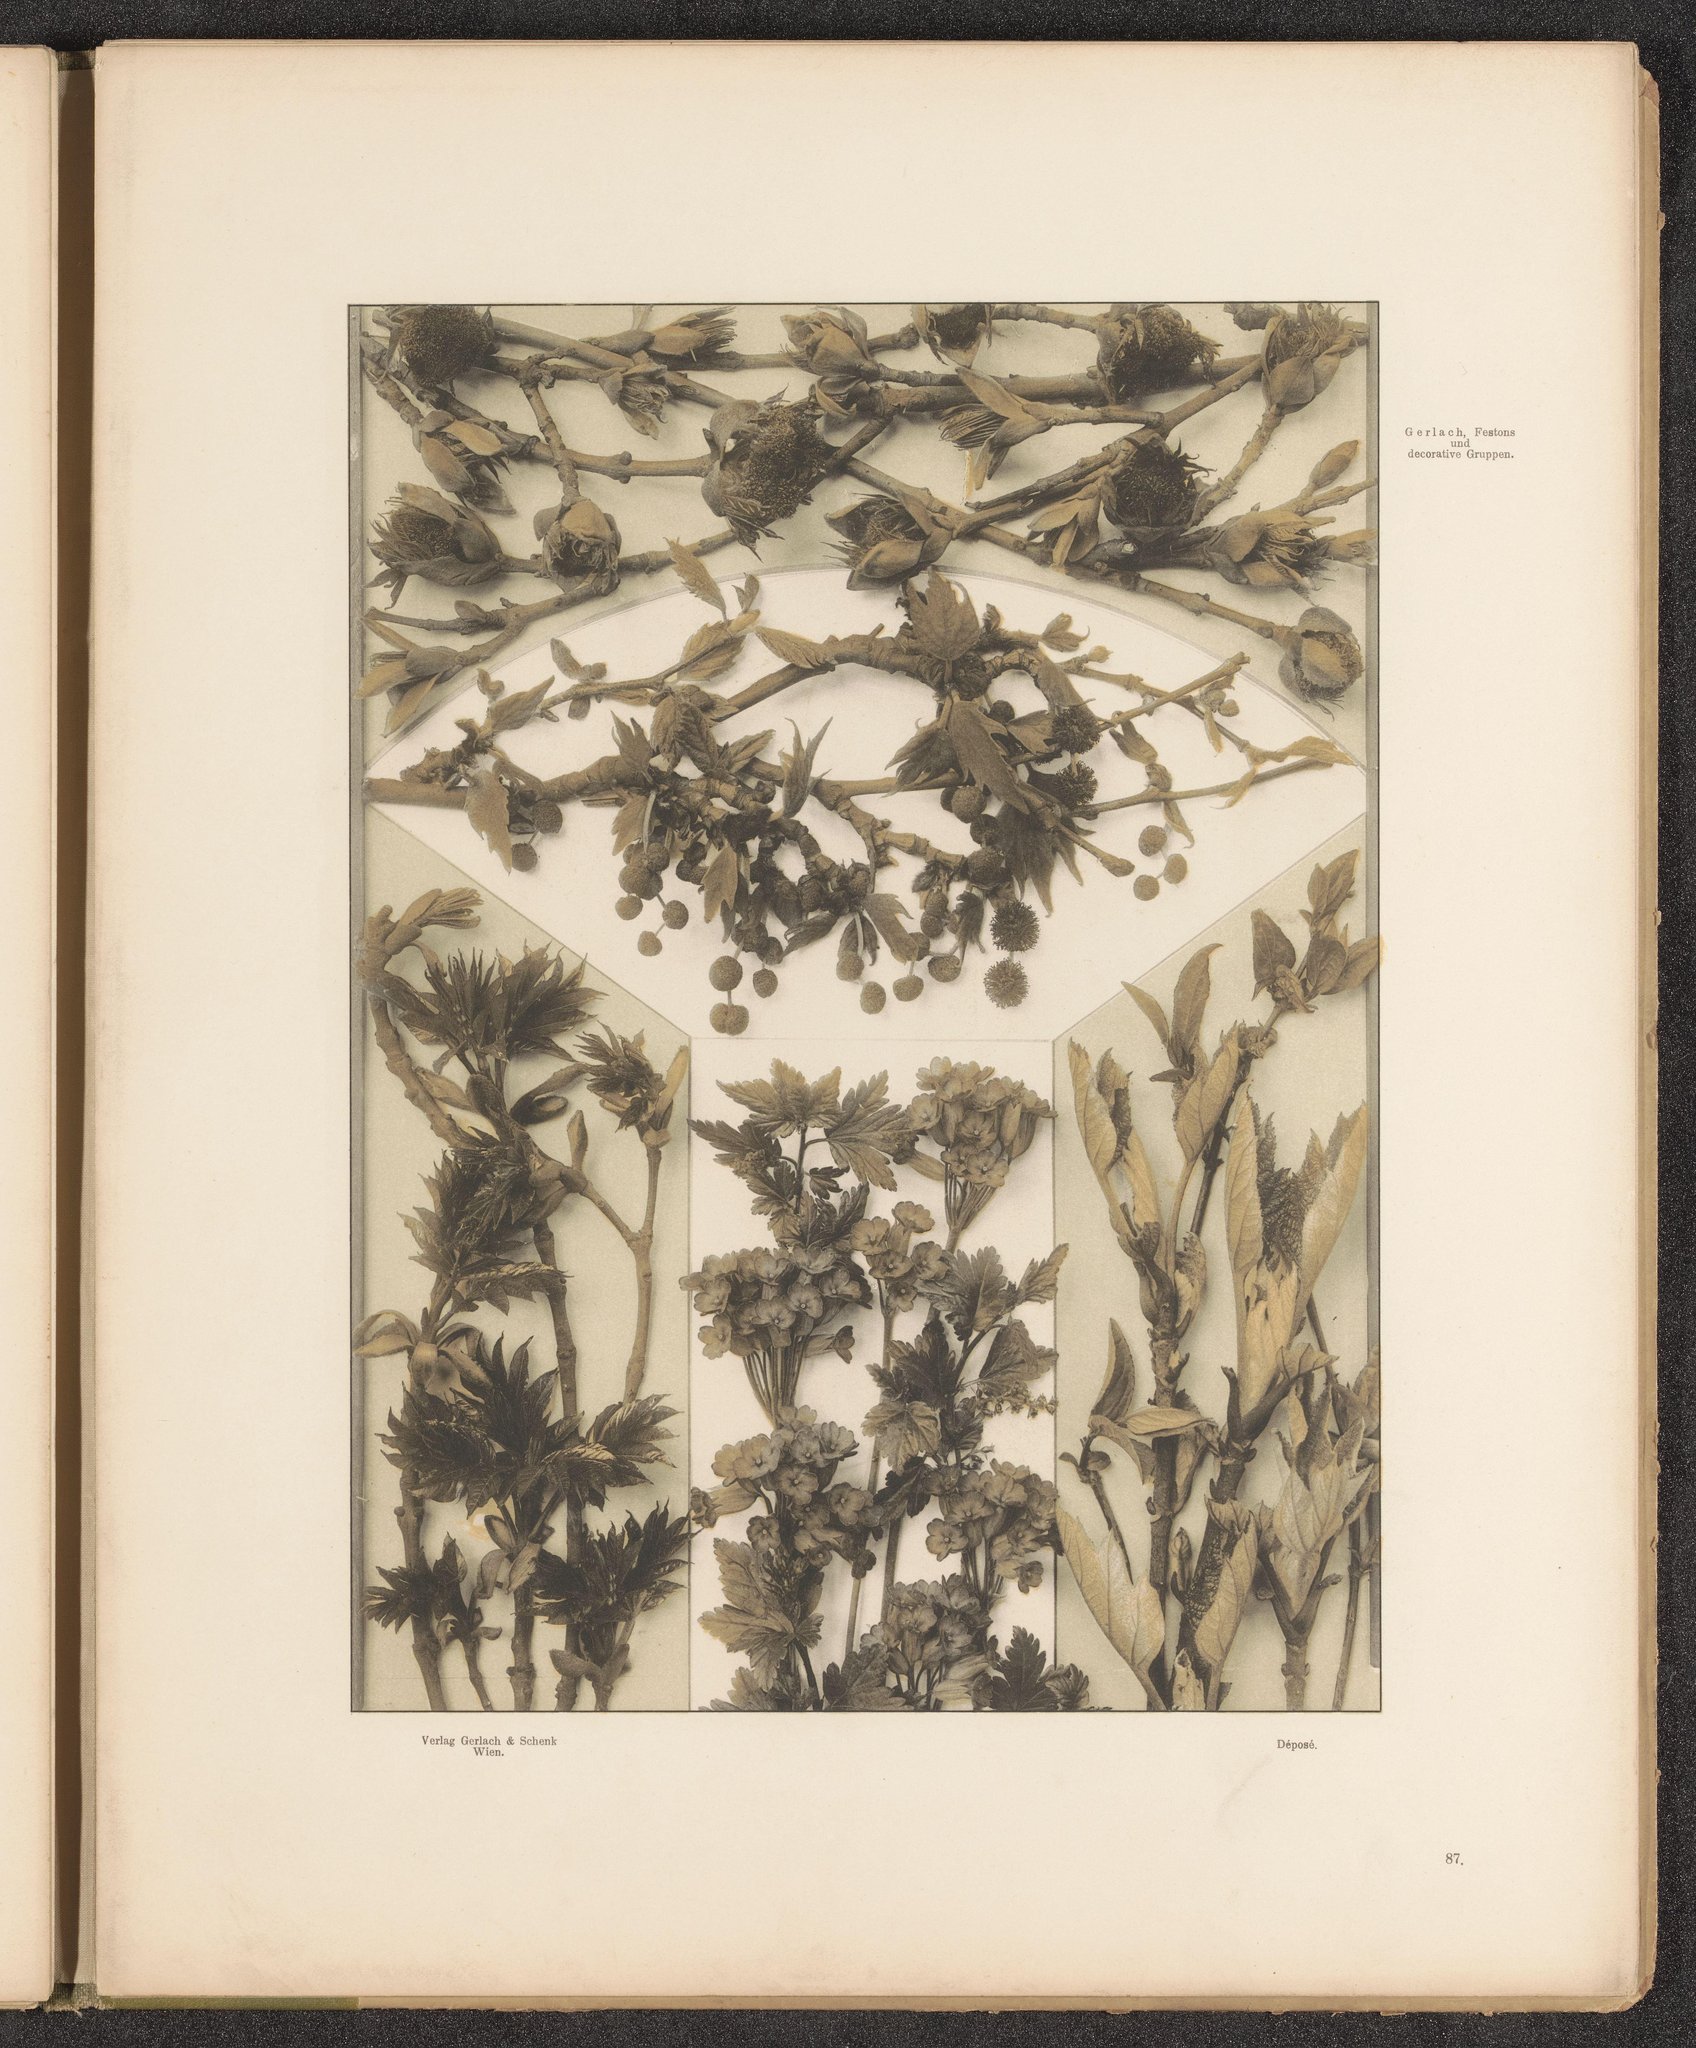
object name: page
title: Vlakken met eikenscheuten, plataanscheuten en aalbesscheuten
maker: Anonymous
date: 1887-1897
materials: paper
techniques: photograph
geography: vienna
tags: trees (+ bulb)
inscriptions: number: ‘87.’